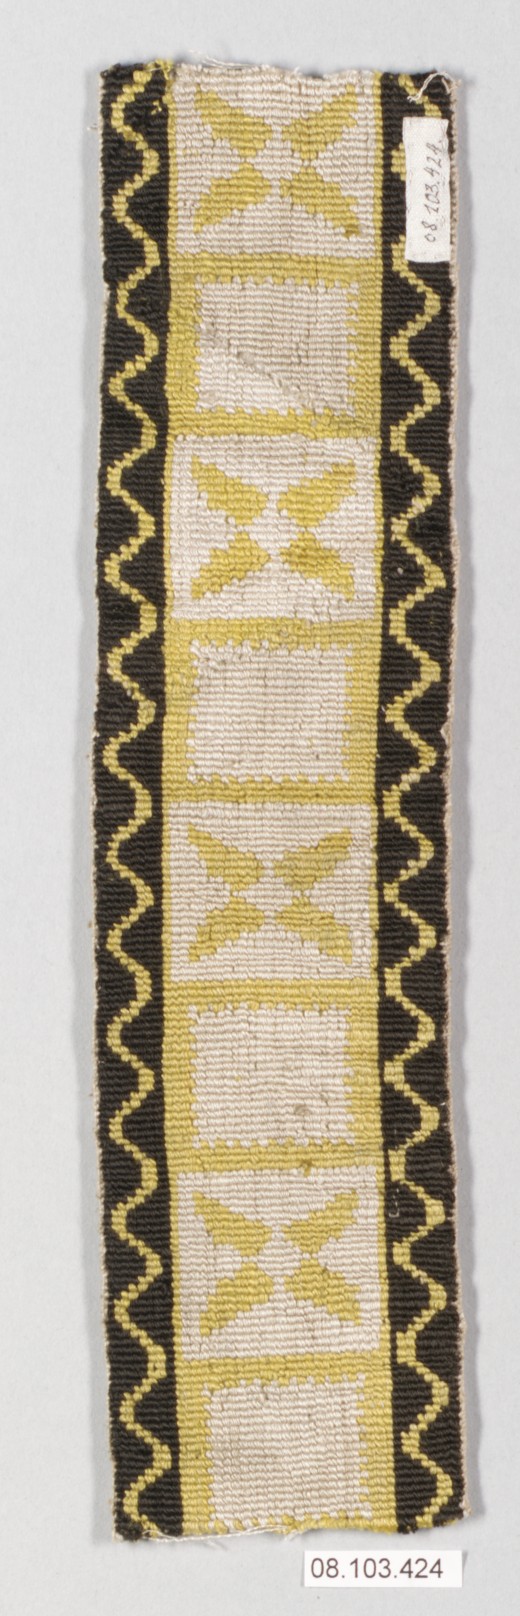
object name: galloon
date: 1801-1900